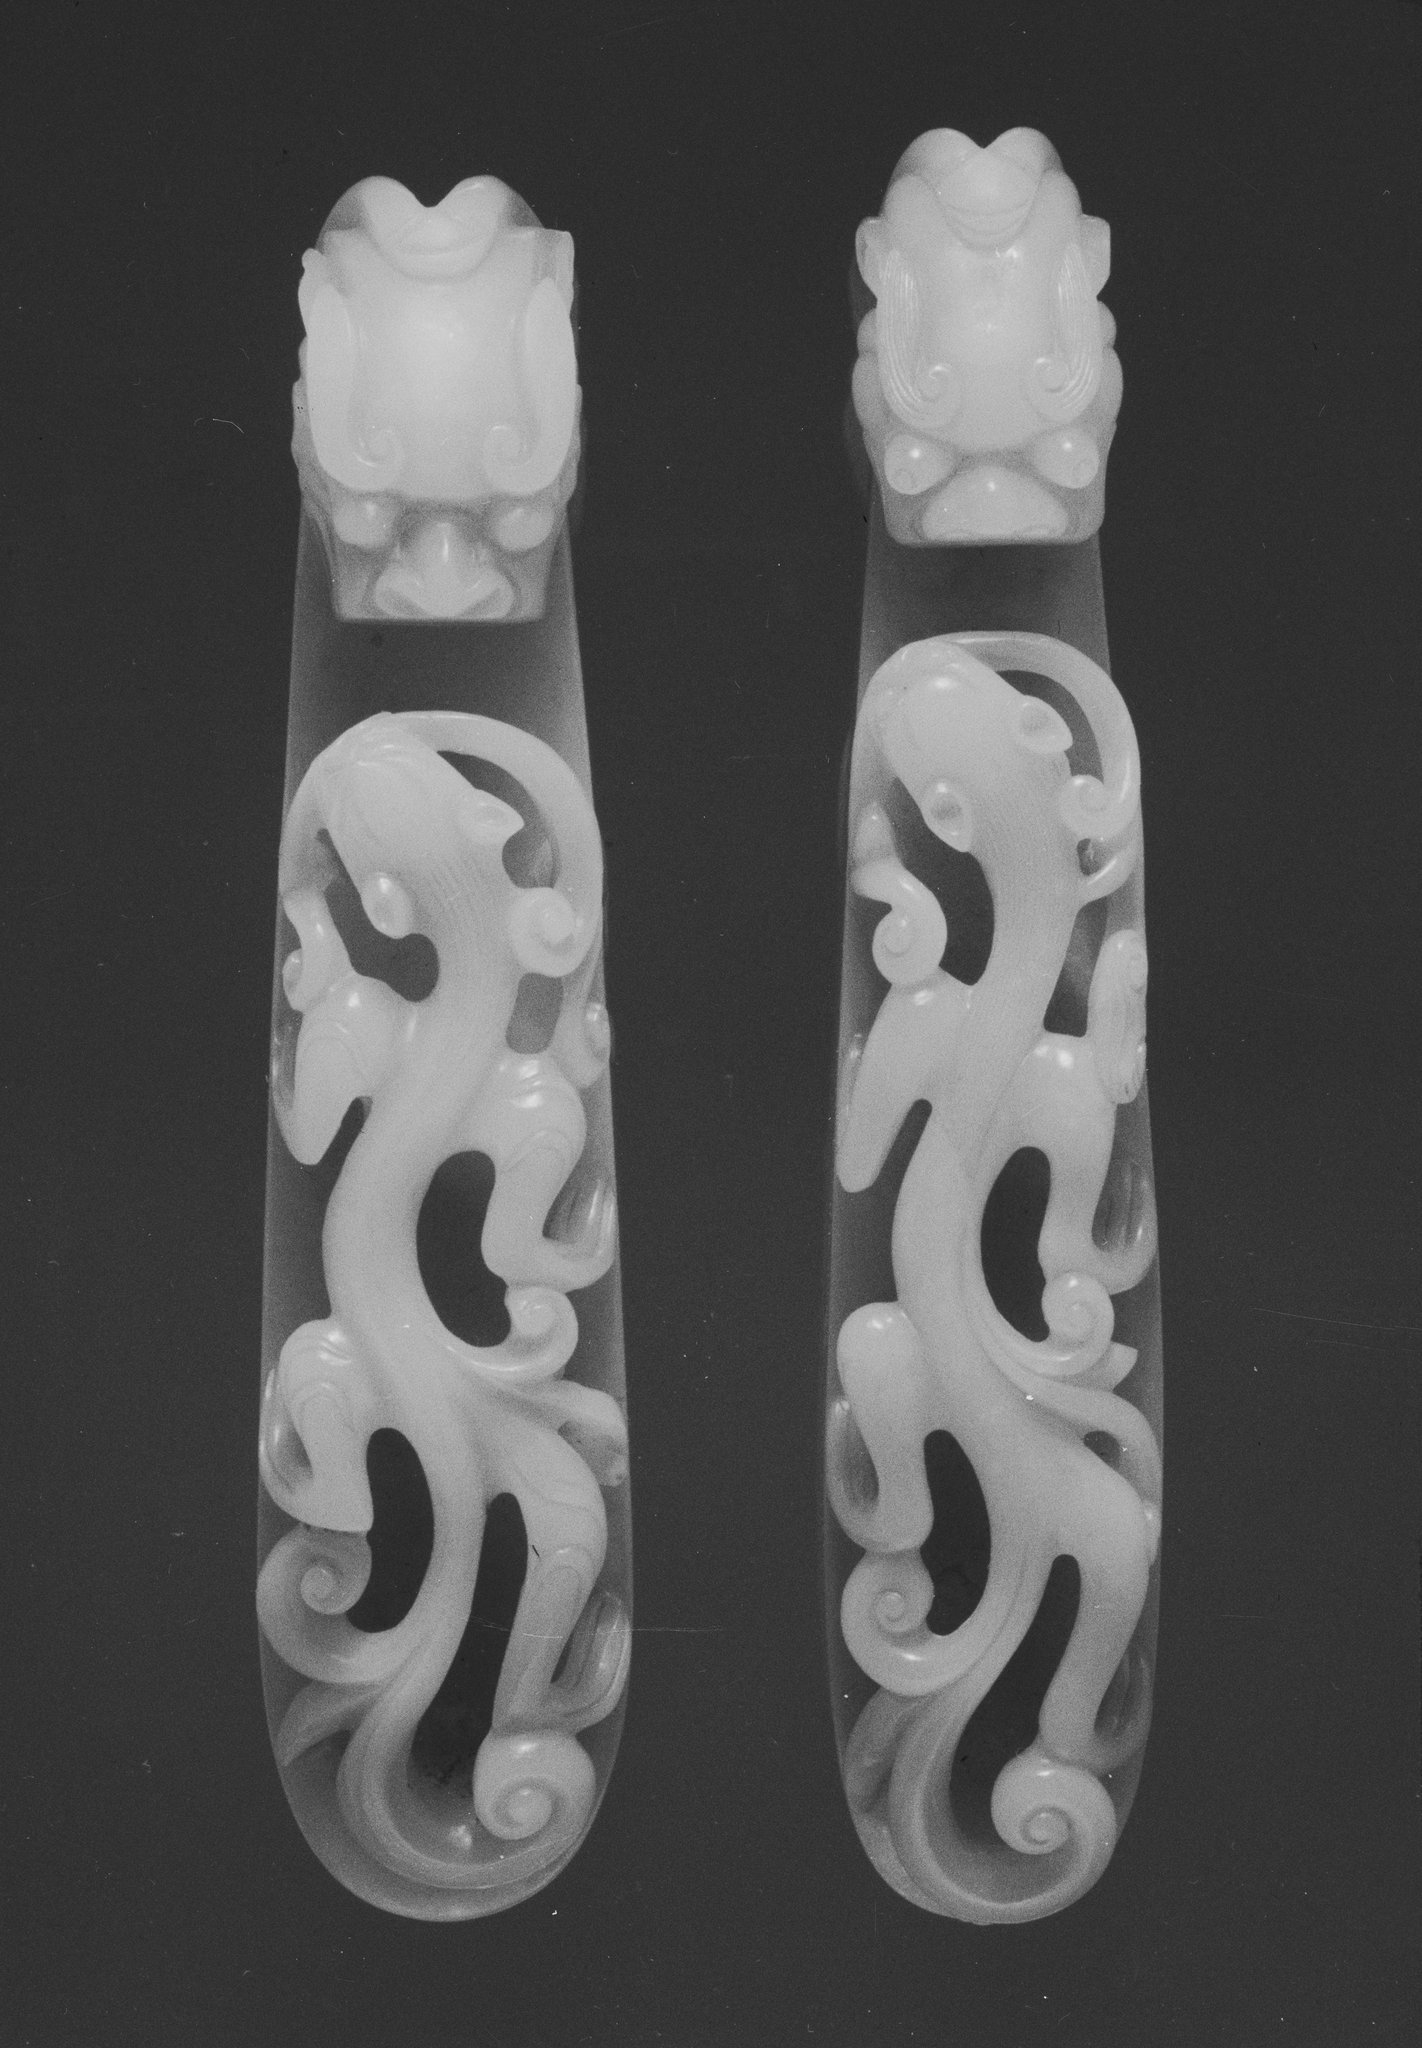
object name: belt buckle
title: Belt buckles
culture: chinese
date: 1701-1800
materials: jade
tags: dragons